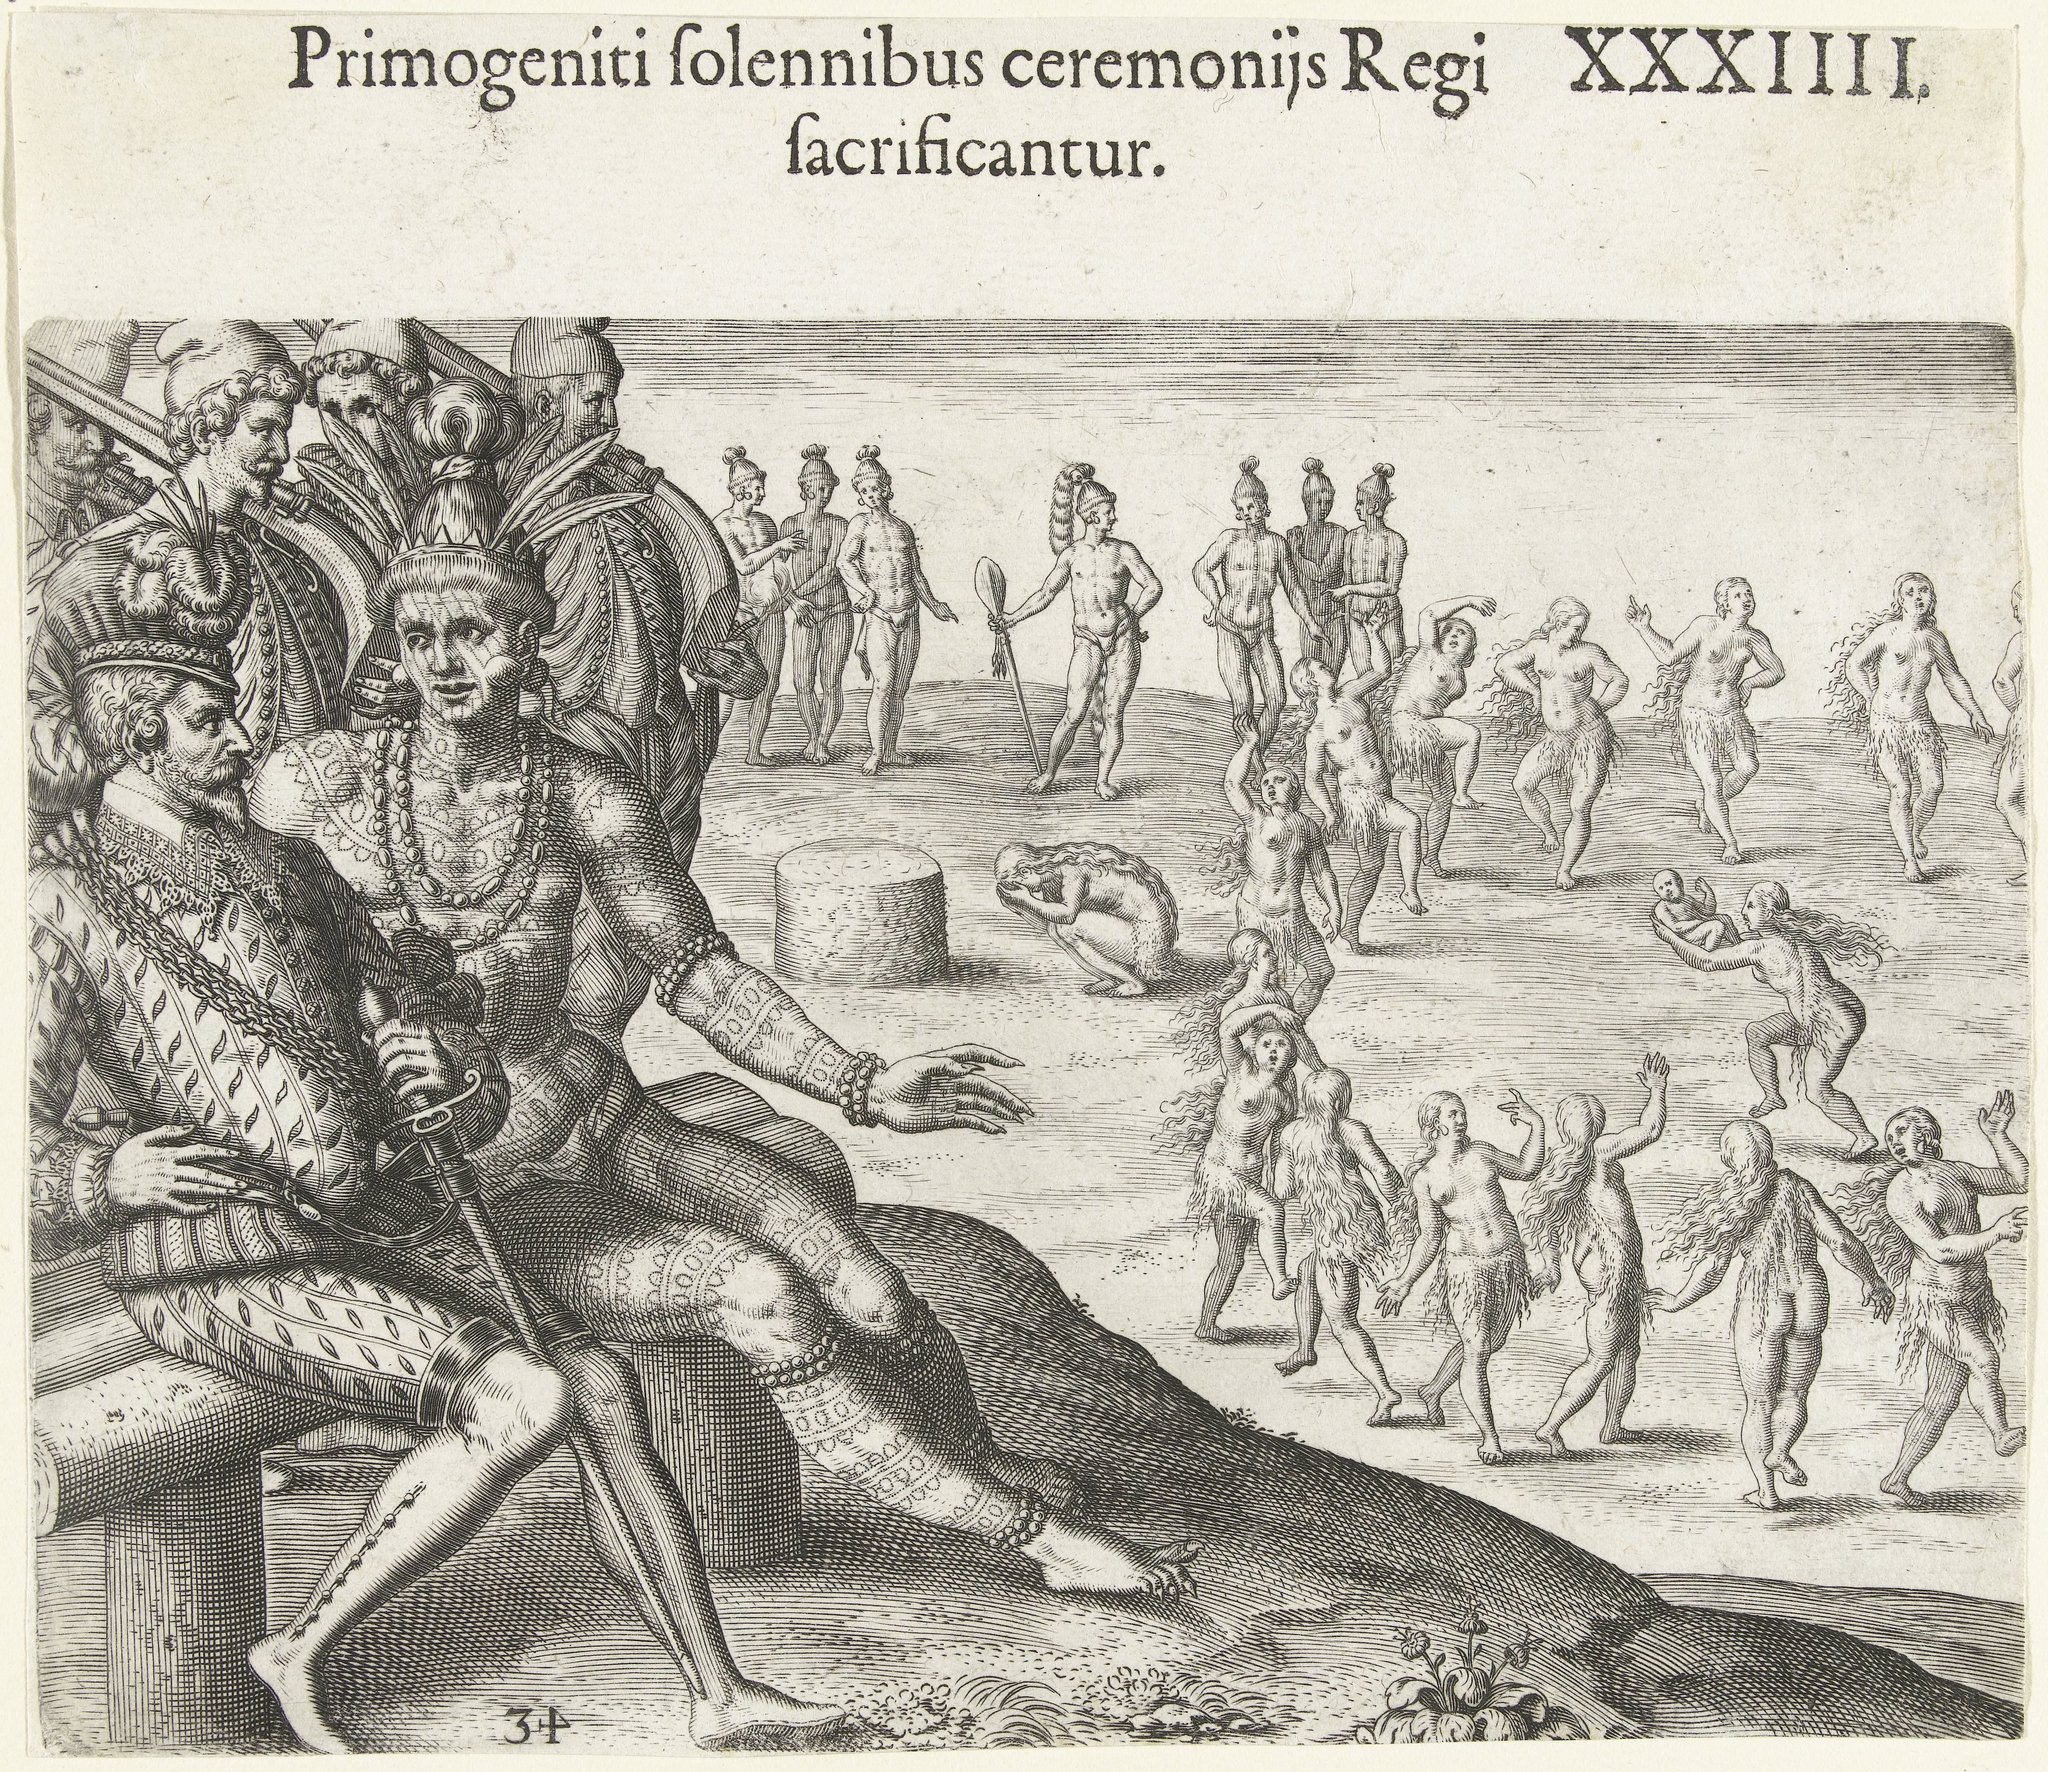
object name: print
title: Offerritueel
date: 1591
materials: paper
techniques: engraving, letterpress printing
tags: human sacrifice ~ american indian religions, native peoples of the americas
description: De leider van een oorspronkelijk Amerikaans volk en een Europeaan kijken naar een offerritueel. De vrouwen dansen in een cirkel. De mannen staan ernaar te kijken. In het midden van de cirkel danst een vrouw met een baby. Buiten de cirkel hurkt een vrouw bij een offerblok op de grond.